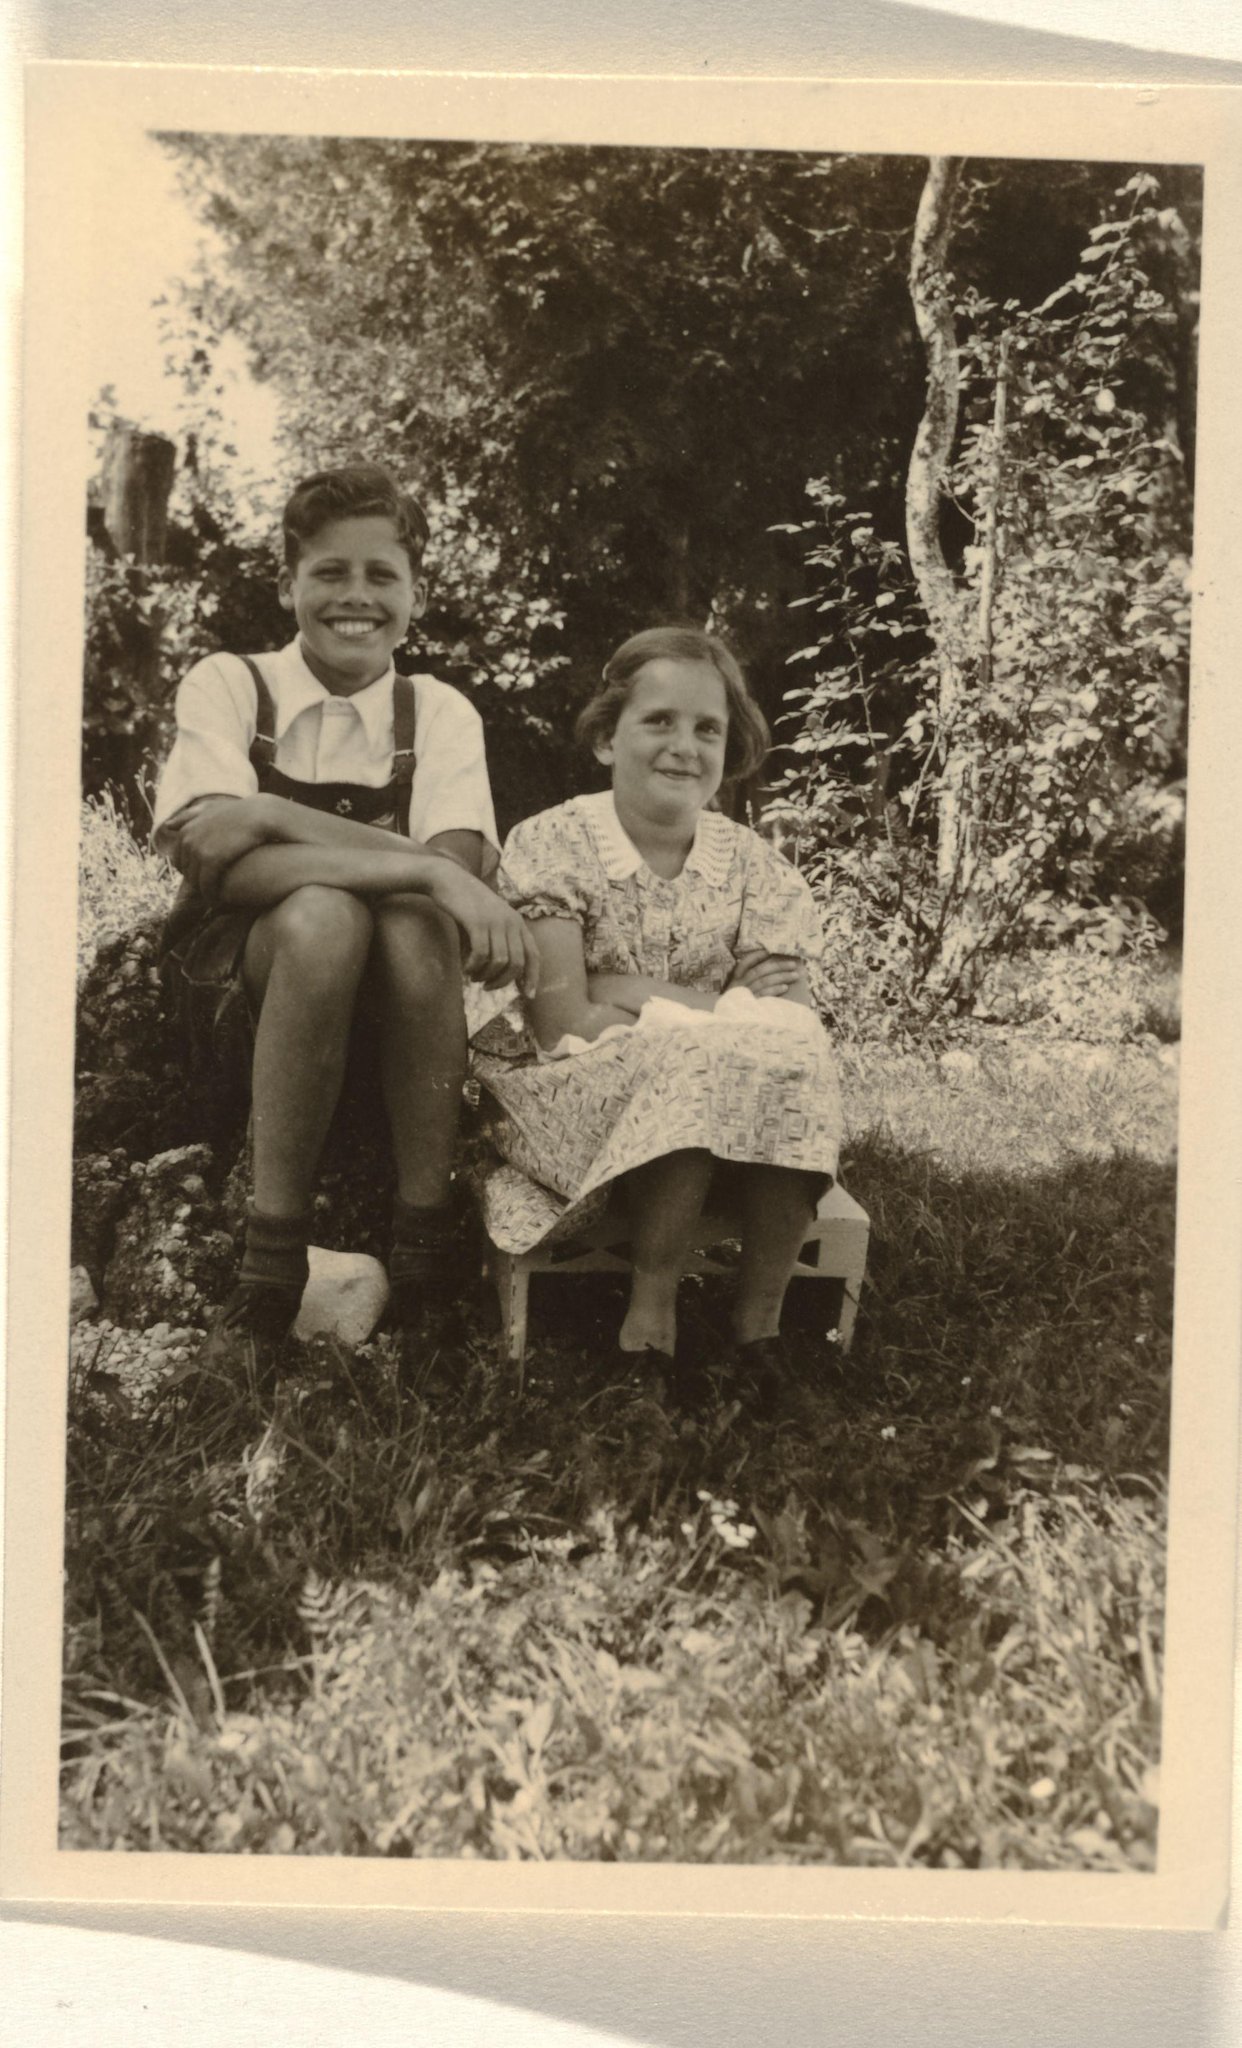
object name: photograph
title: Isabel Wachenheimer en Walter gezeten in een bos bij Krün, augustus 1936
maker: Anonymous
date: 1908-1936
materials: photographic support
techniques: gelatin silver print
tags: leiden, isabel wachenheimer-elon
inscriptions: inscription: ‘Aug.1936. Isabel u. Walter in Krün.’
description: Isabel Wachenheimer (links) en Walter (rechts) gezeten in een bos bij Krün.